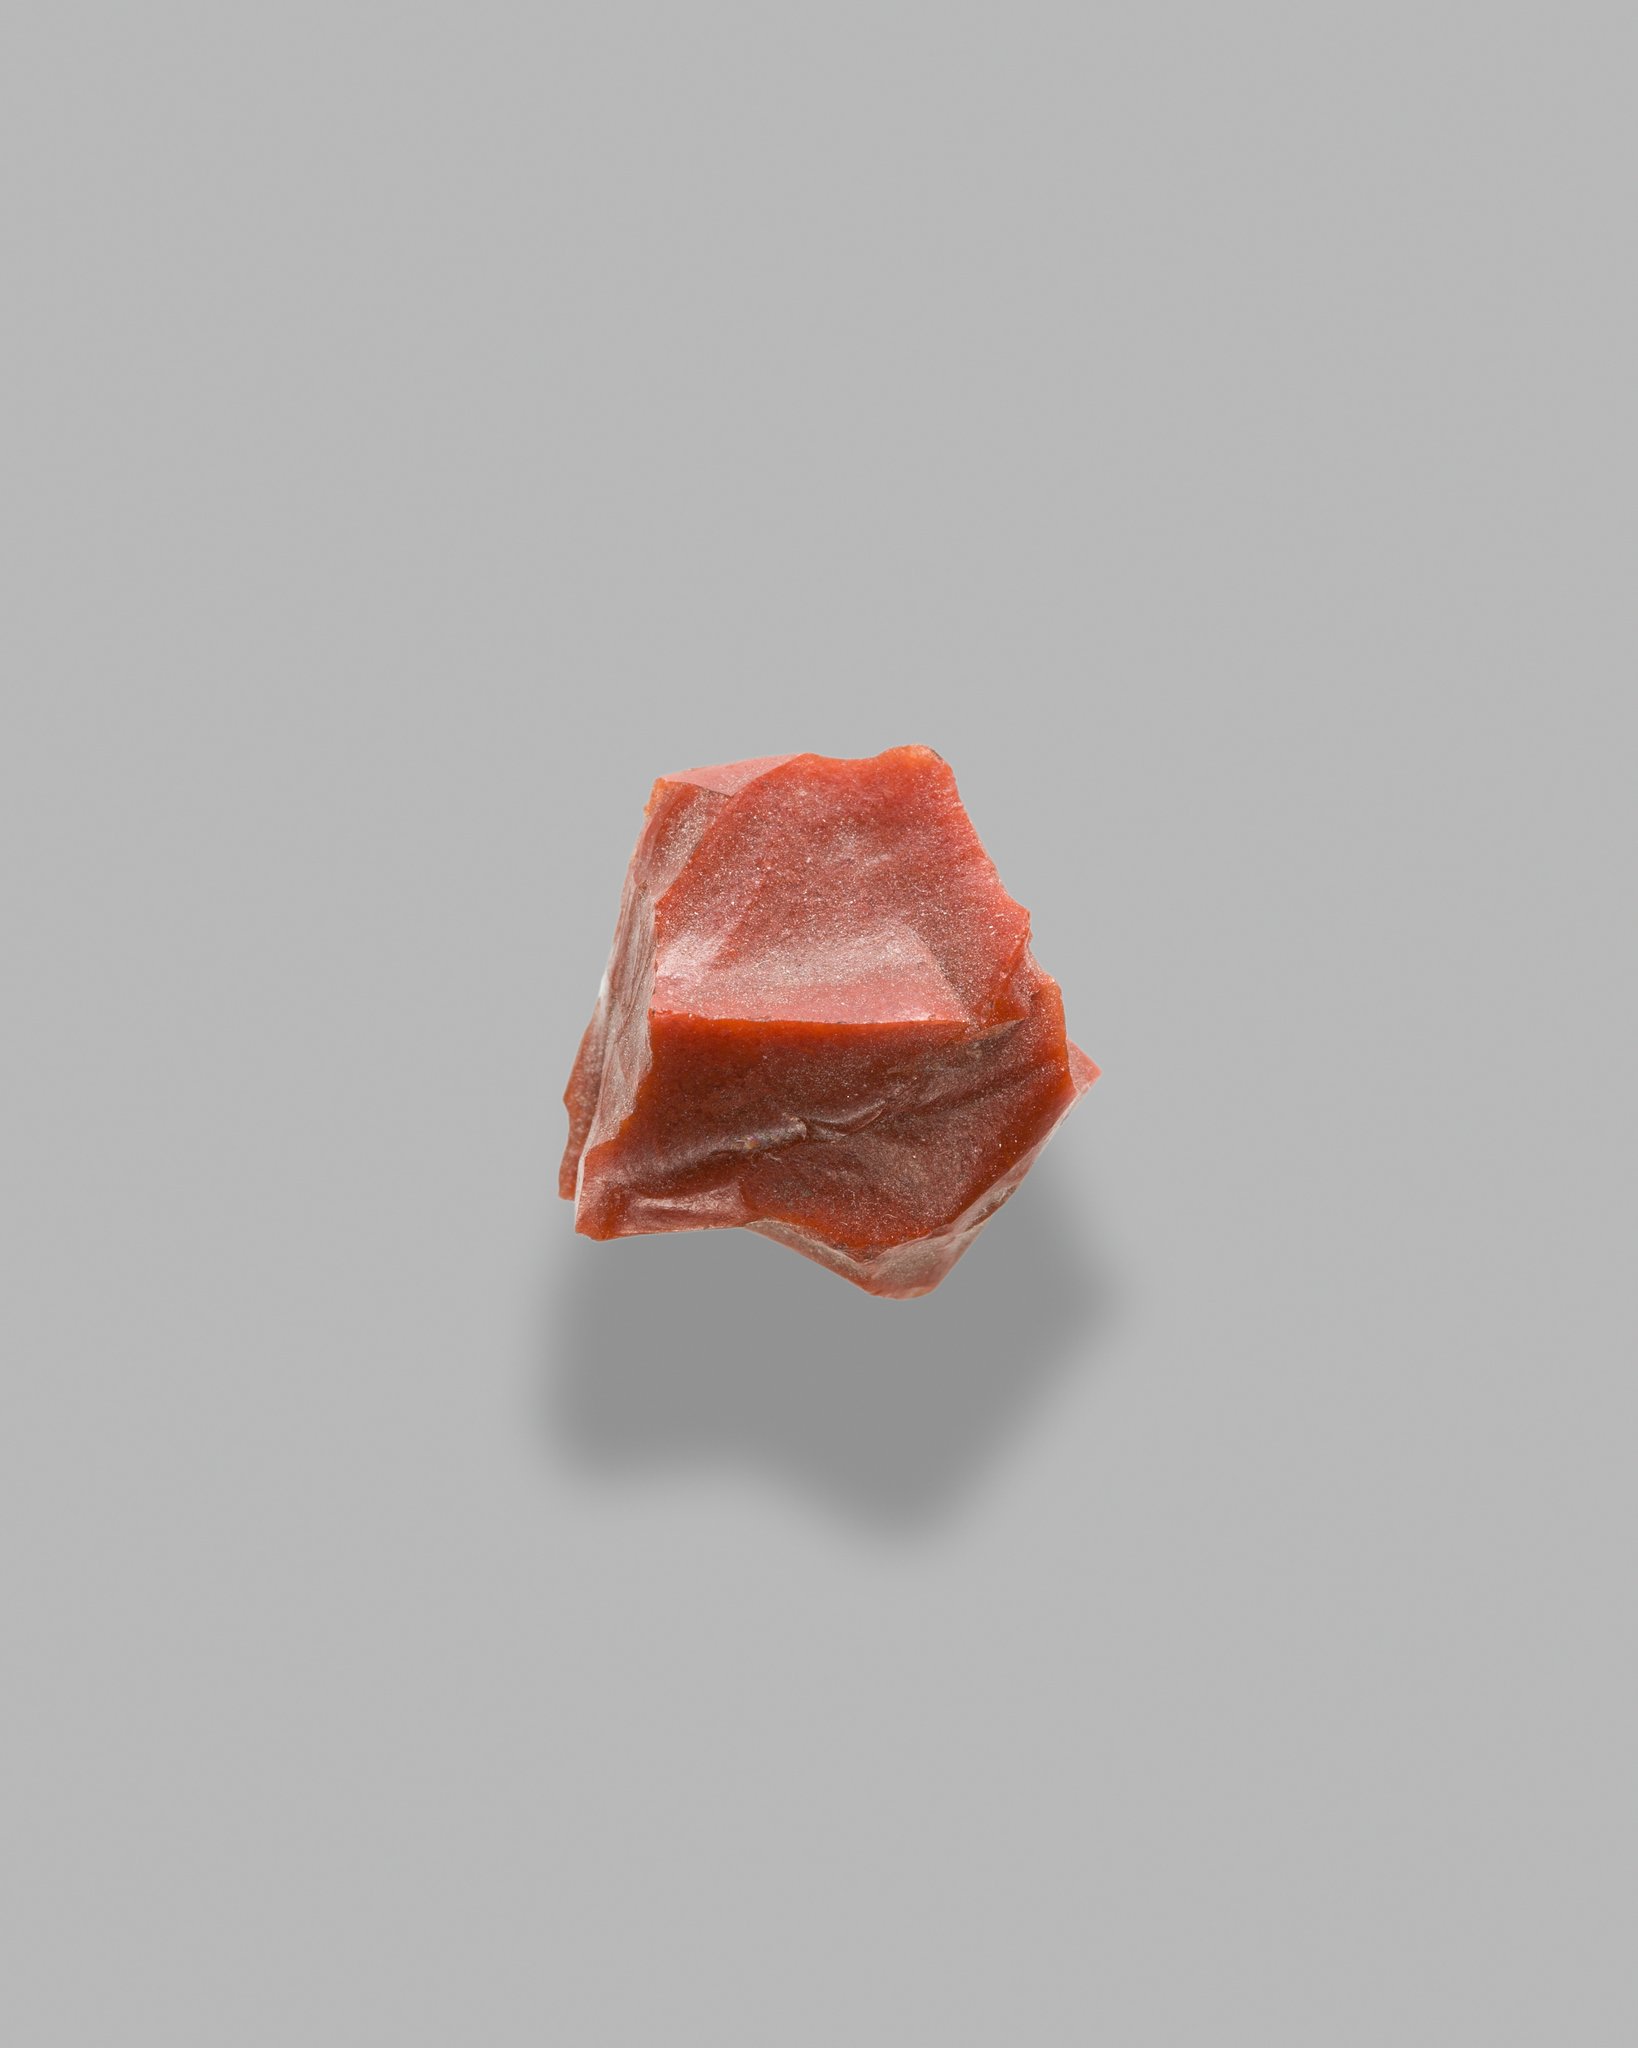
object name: fragment, red jasper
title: Lump of Red Jasper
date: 1153-1147 BCE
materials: jasper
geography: egypt